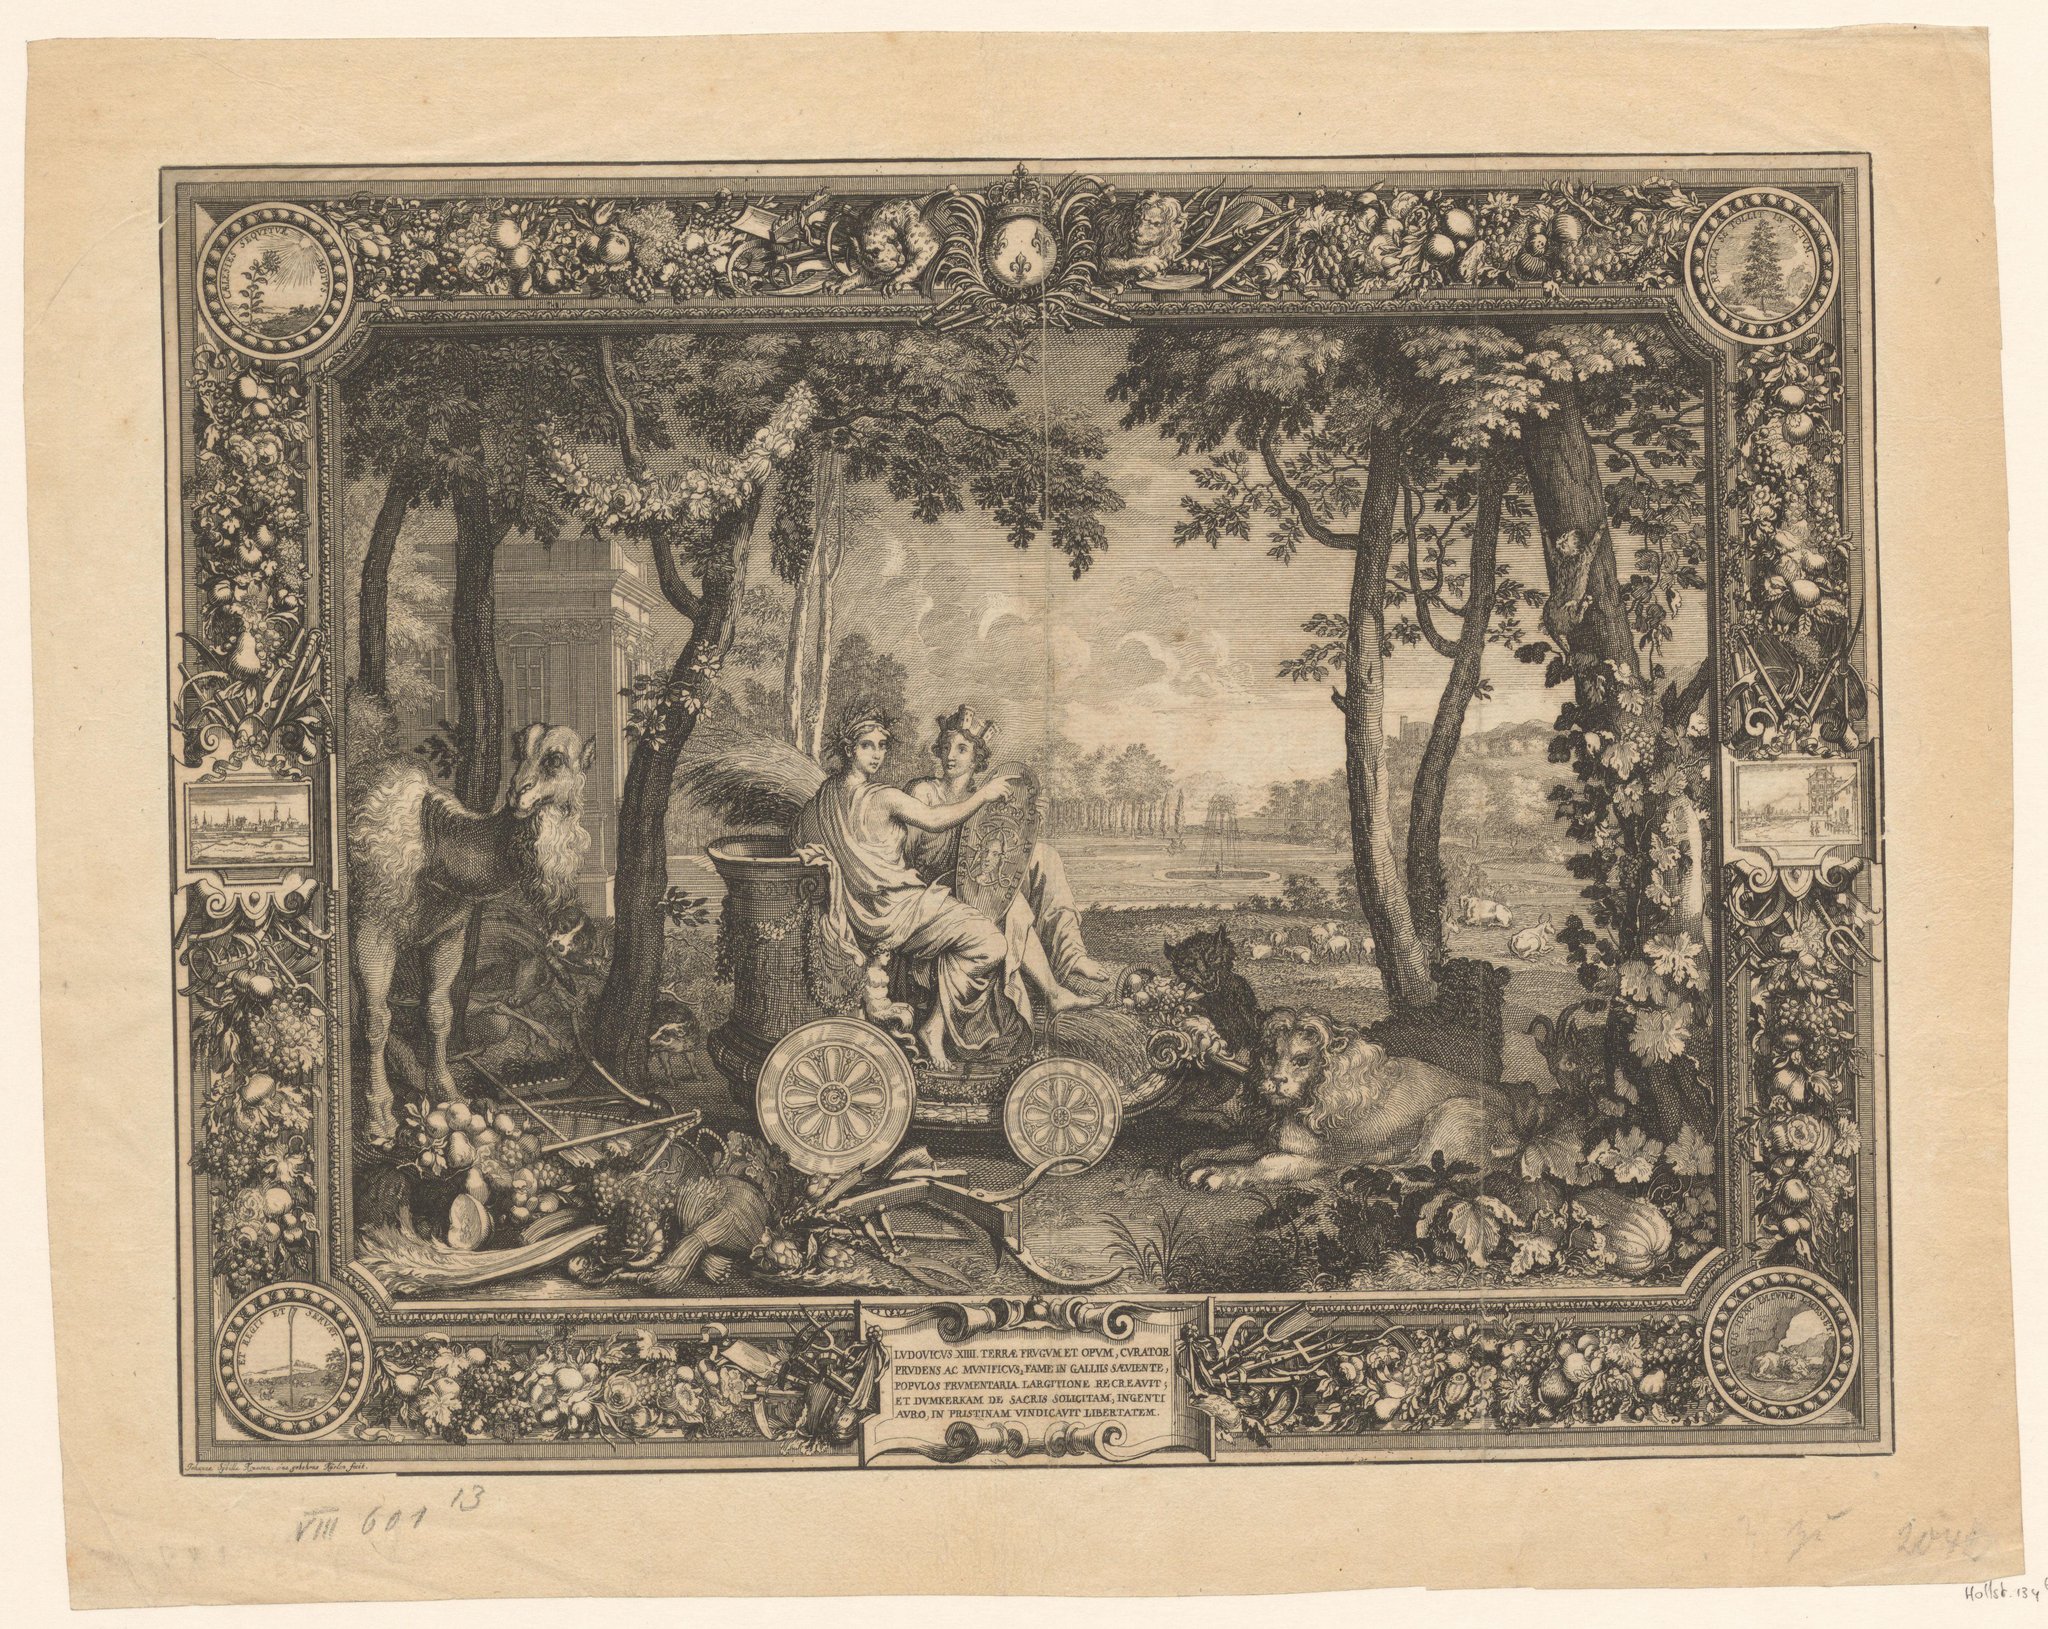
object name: print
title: Ceres en Cybele in een strijdwagen omringd door dieren in een tuin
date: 1660-1717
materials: paper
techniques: etching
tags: (story of) ceres (demeter), public gardens, park - ii - ideal city, specific aspects, allegorical aspects of cybele; cybele as patroness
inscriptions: collector's mark: Lugt 1337, collector's mark: Lugt 2228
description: Voorsteling omgeven door een ornamentrand met guirlandes en 'tropaia' van landbouwwerktuigen. Tekst in het Latijn in de cartouche onderaan en bij de emblemen.